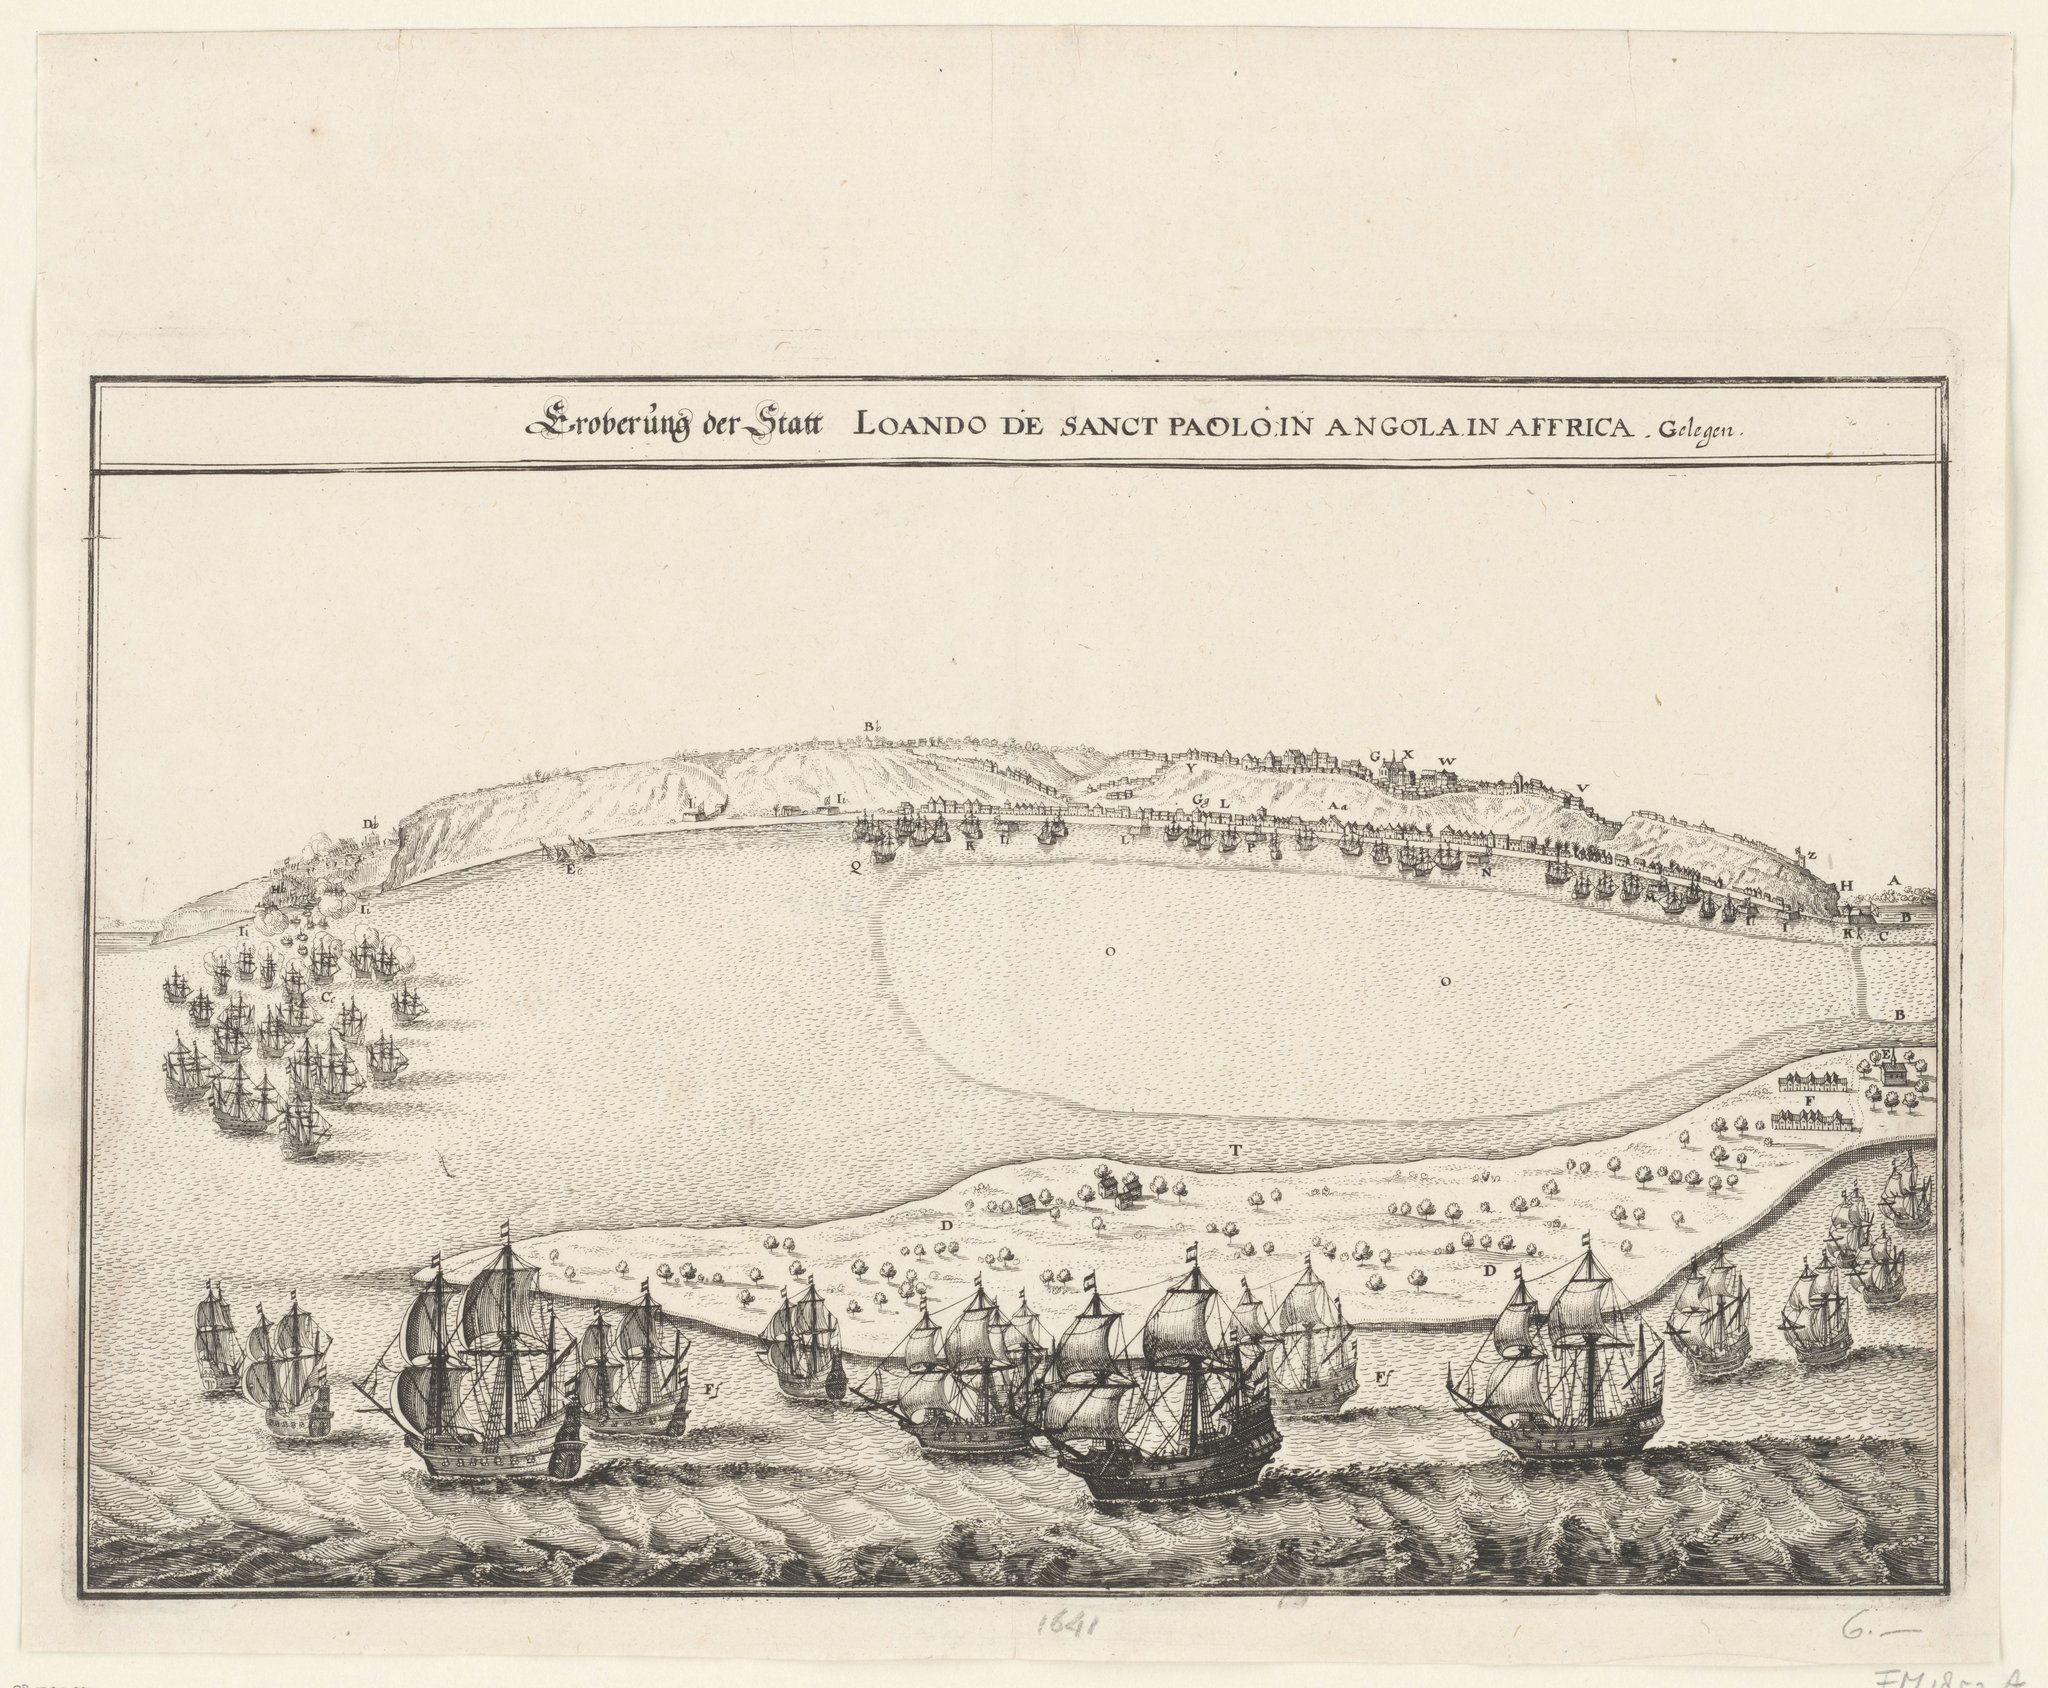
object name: print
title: Verovering van Luanda, 1641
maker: Anonymous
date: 1651-1659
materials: paper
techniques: etching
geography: germany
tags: west-indische compagnie, scheveningen, admiraal, cornelis corneliszoon jol (alias houtebeen), luanda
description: Kopie naar de anonieme prent in: I. Commelin, Frederick Hendrick van Nassauw Prince van Orangien : zyn leven en bedryf, Jodocus Janssonius, Amsterdam 1651, dl. 2, fol. 111 (FMH 1851). Niet in Frederik Muller; door het RPK toegevoegd nummer.